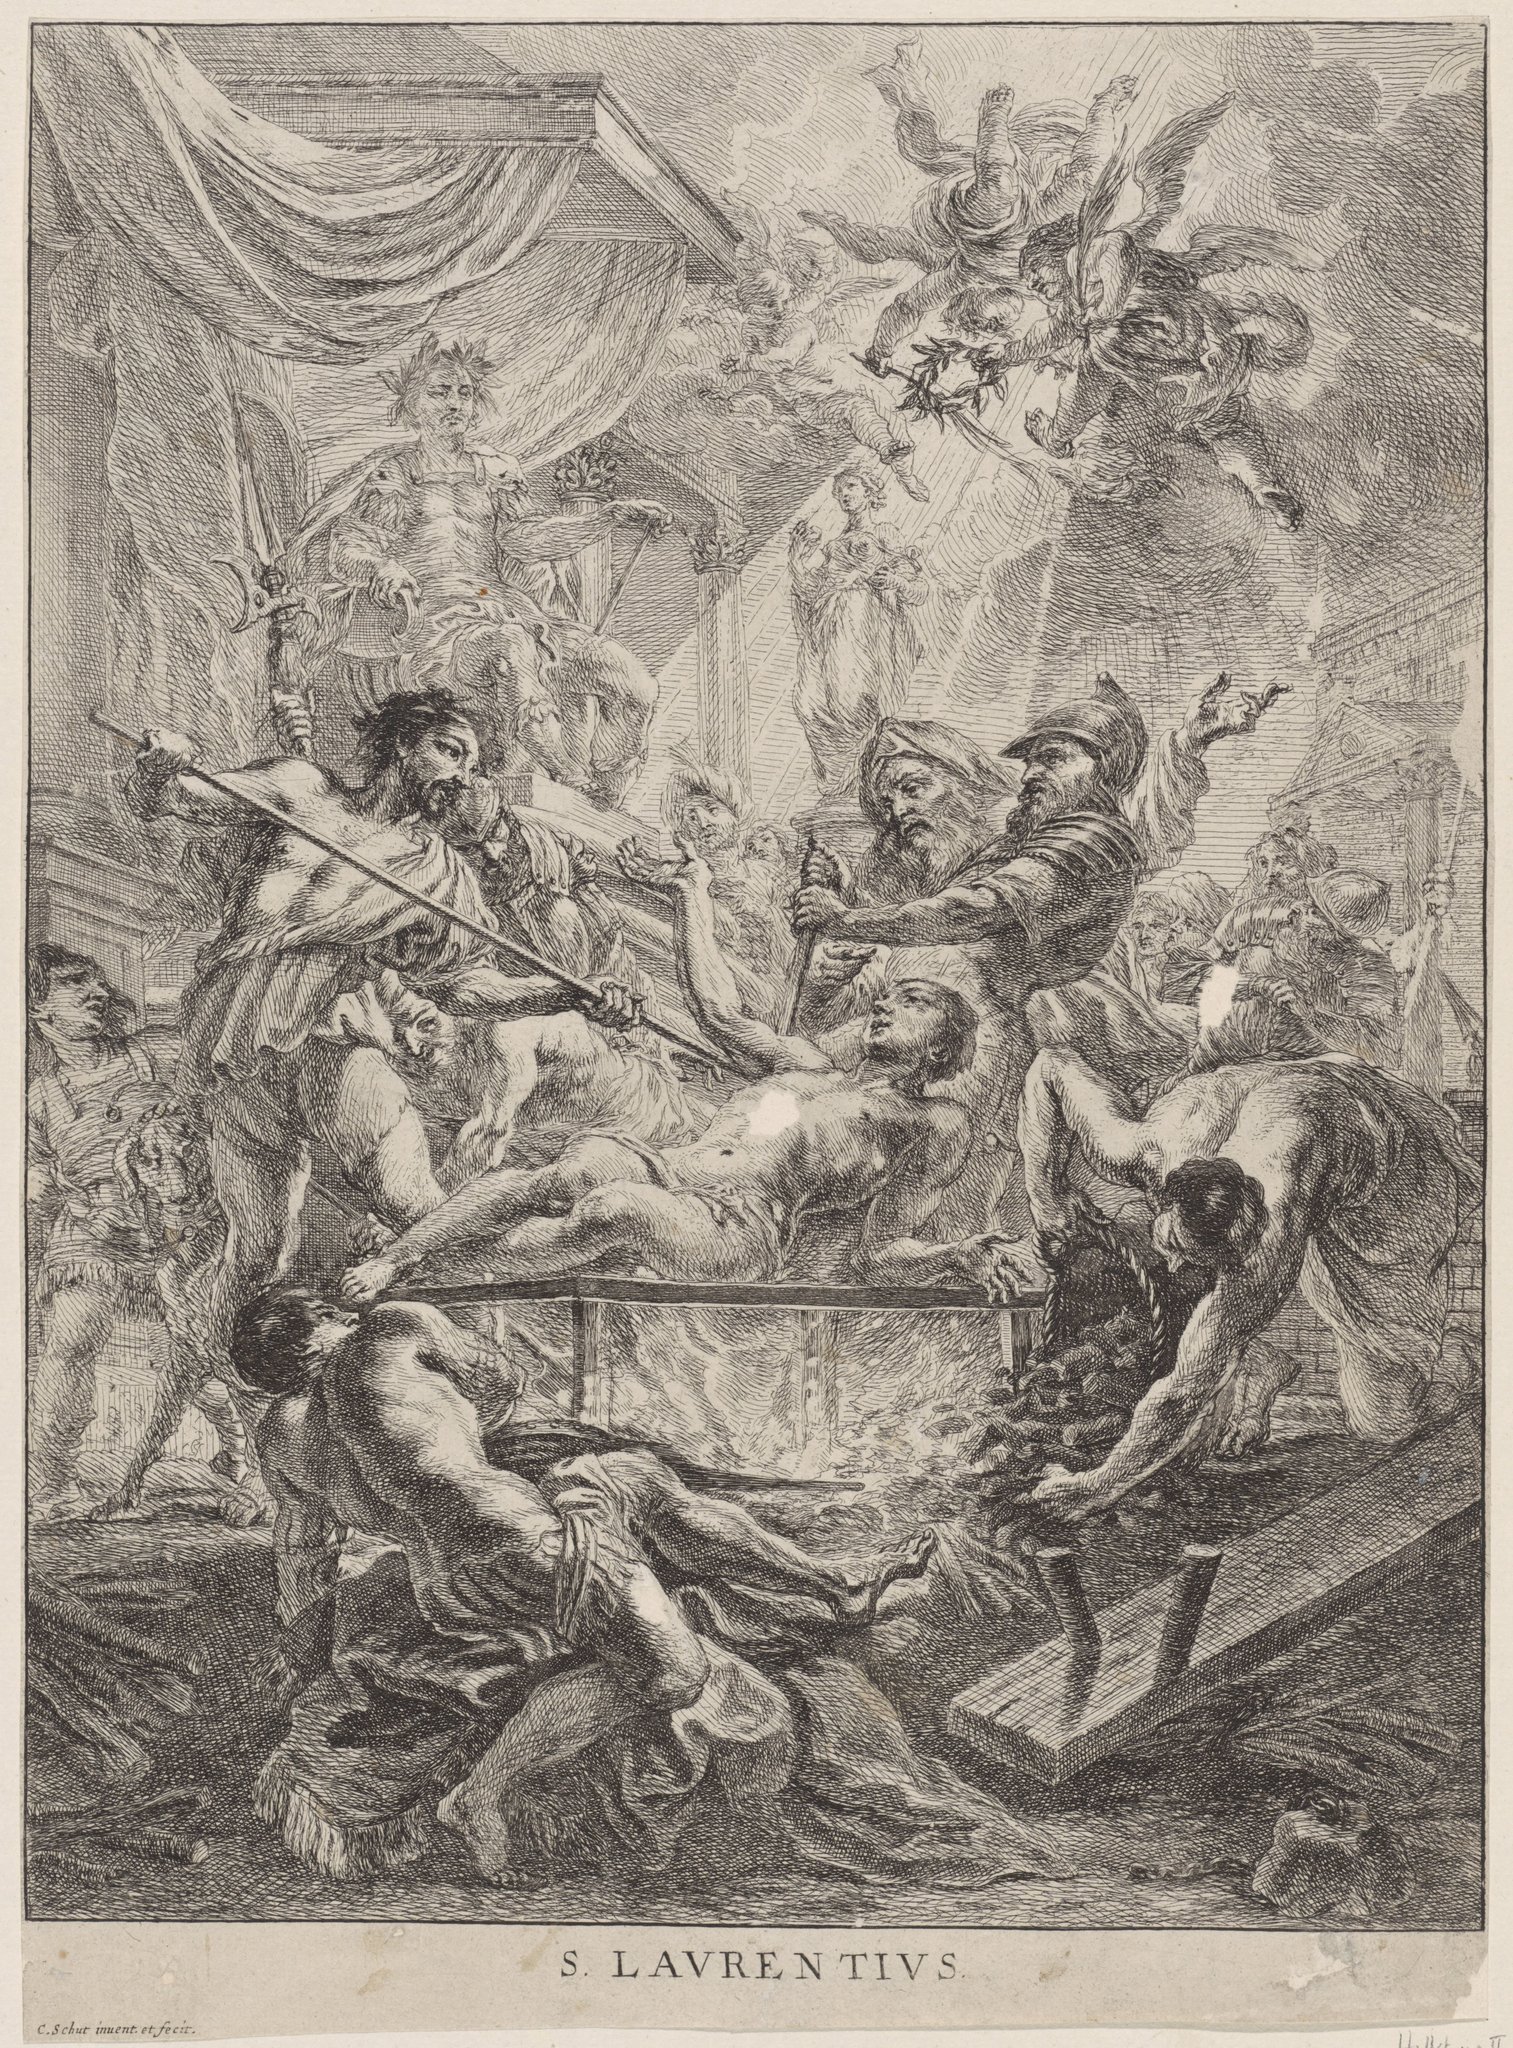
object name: print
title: Het martelaarschap van de H. Laurentius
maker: cornelis schut (i)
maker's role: draughtsman, print maker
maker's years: 1597-1655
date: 1618-1655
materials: paper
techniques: etching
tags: martyrdom, suffering, misfortune, death of st. laurence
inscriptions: collector's mark: Lugt 2228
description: De diaken Laurentius wordt geroosterd boven een vuur. Hij richt zich half op om zich om te draaien. Op de voorgrond zijn dienaren bezig het vuur verder op te stoken met een blaasbalg en extra brandstof.De Romeinse prefect kijkt vanaf een stoel op een balkon toe. Rondom Laurentius een grote groep toeschouwers. In de lucht twee engelen met een palmtak en een lauwerkrans.